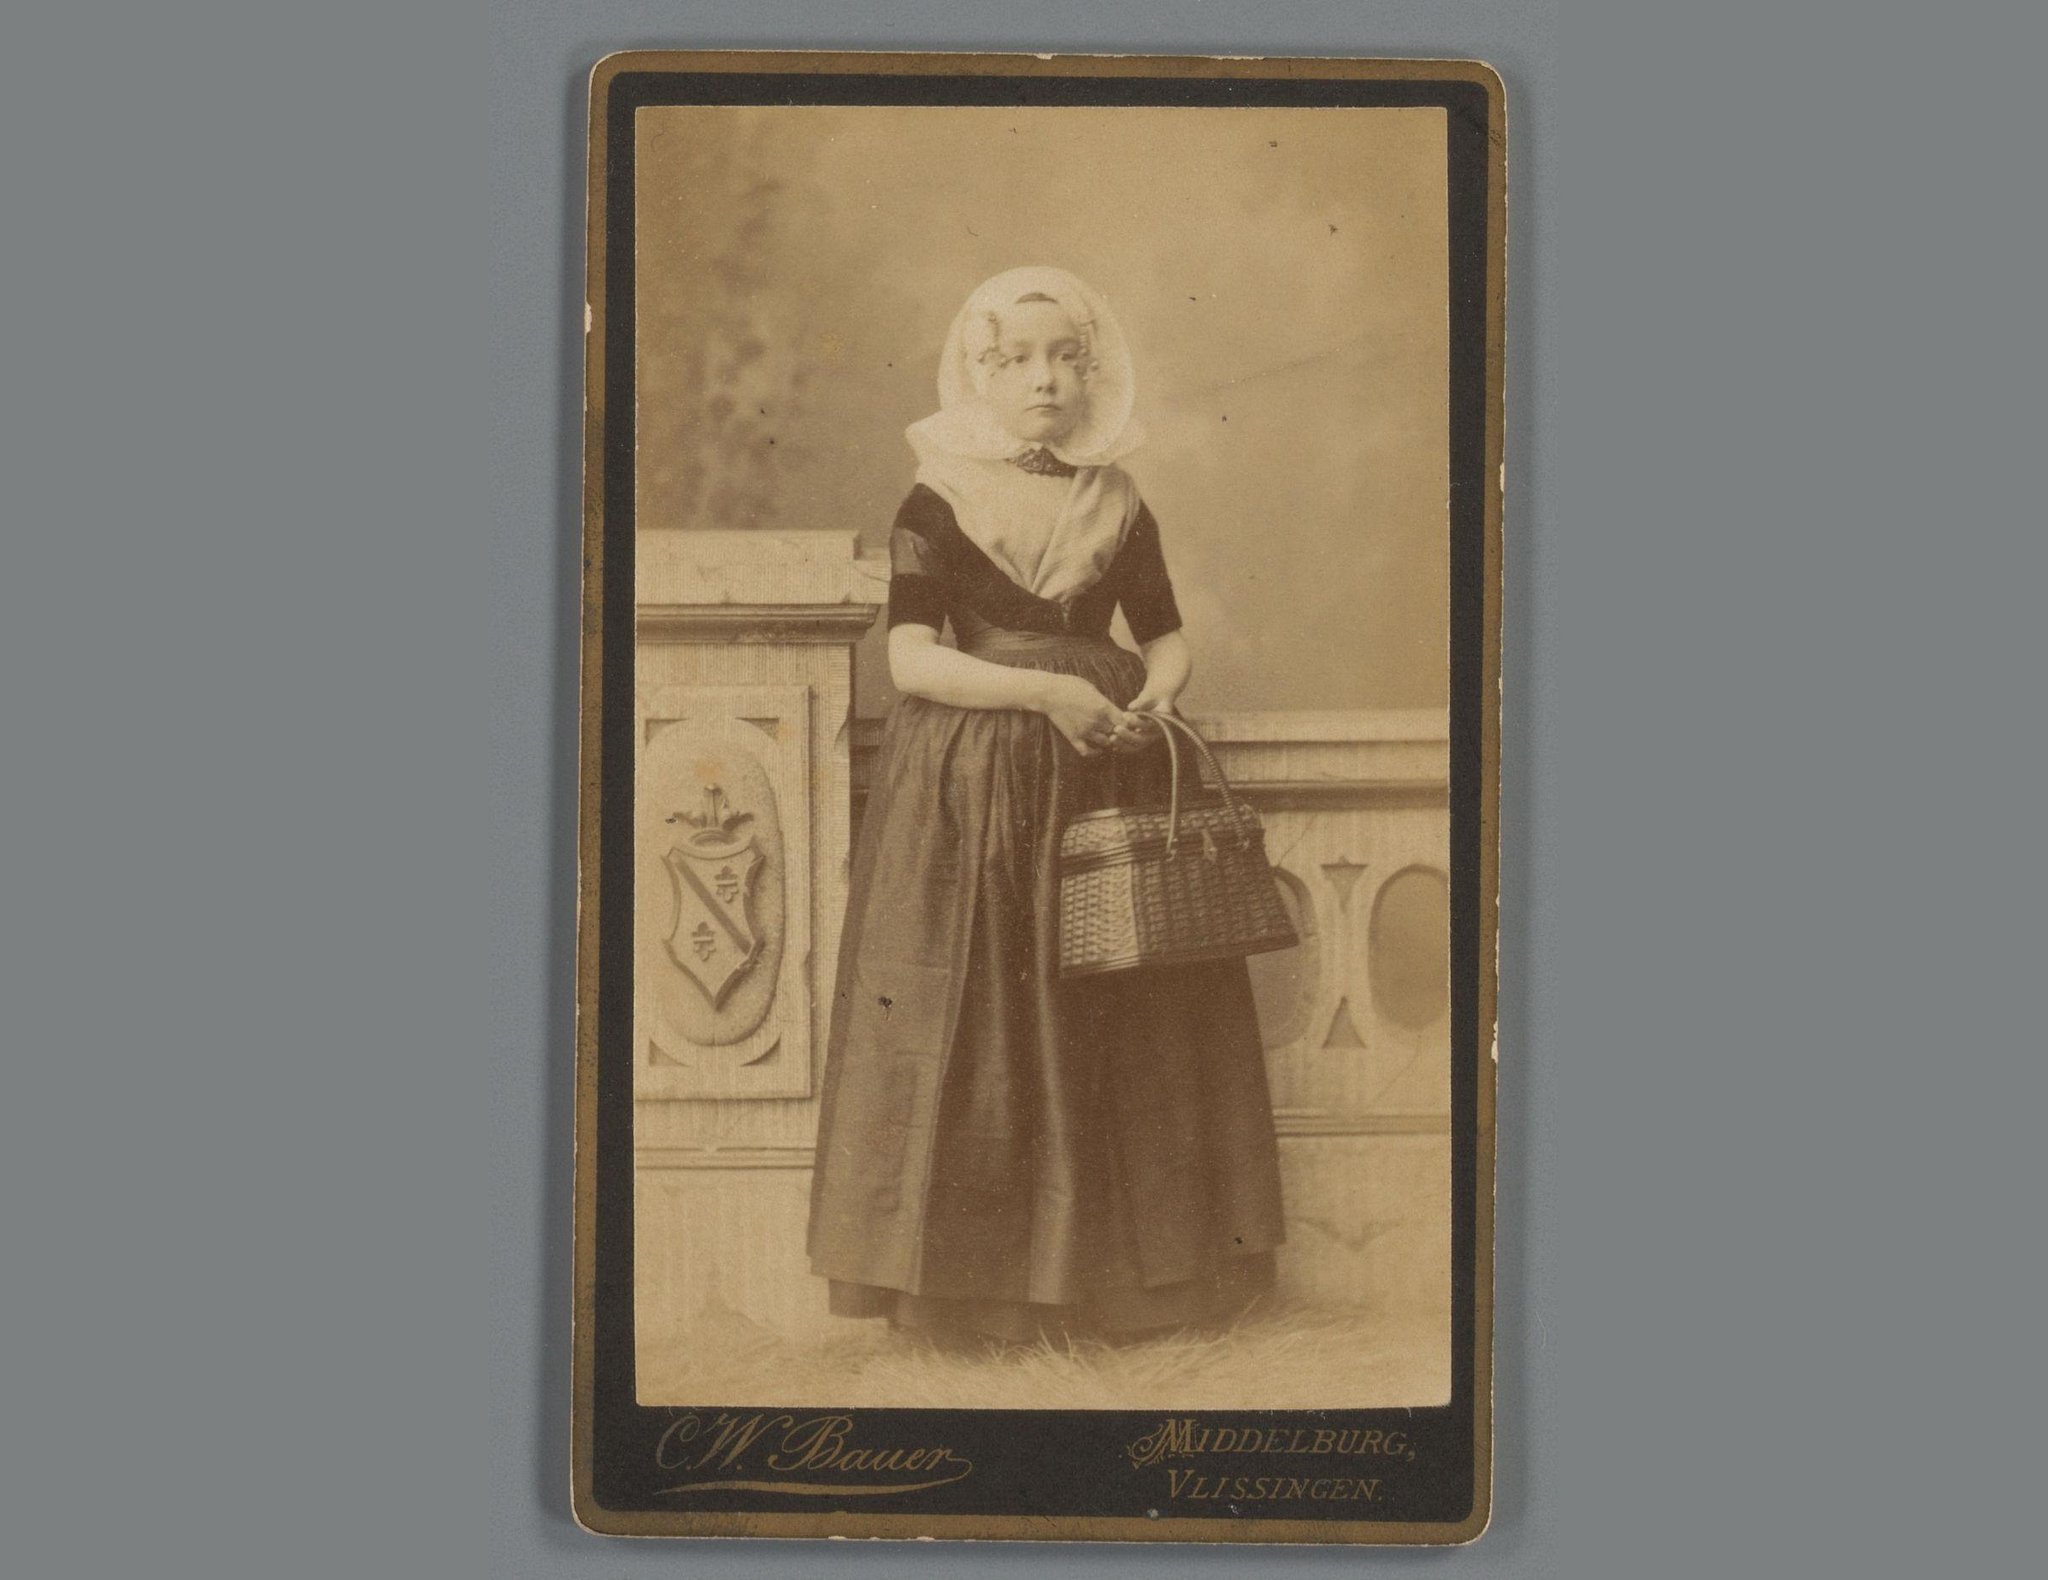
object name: photograph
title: Portret van een onbekend meisje in klederdracht uit de familie en de kring van Eugene van Delden en Belle van Delden-Denninghof Stelling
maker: carl wilhelm bauer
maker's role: fotograaf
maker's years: 1844-1911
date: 1885-1908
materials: cardboard, paper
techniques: albumen print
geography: middelburg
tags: historical persons not known by name - bb - woman, girl (child between toddler and youth), folk costume, regional costume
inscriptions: inscription: ‘C. W. Bauer/ Photograaf./ Middelburg, St. Janstraat/ Vlissingen, Dokkade.’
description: Portret uit de kring van Eugene van Delden (Hartapoera, 1865 - Den Haag, 1954) en Belle van Delden-Denninghof Stelling (Batavia, 1870 - Den Haag, 1947).